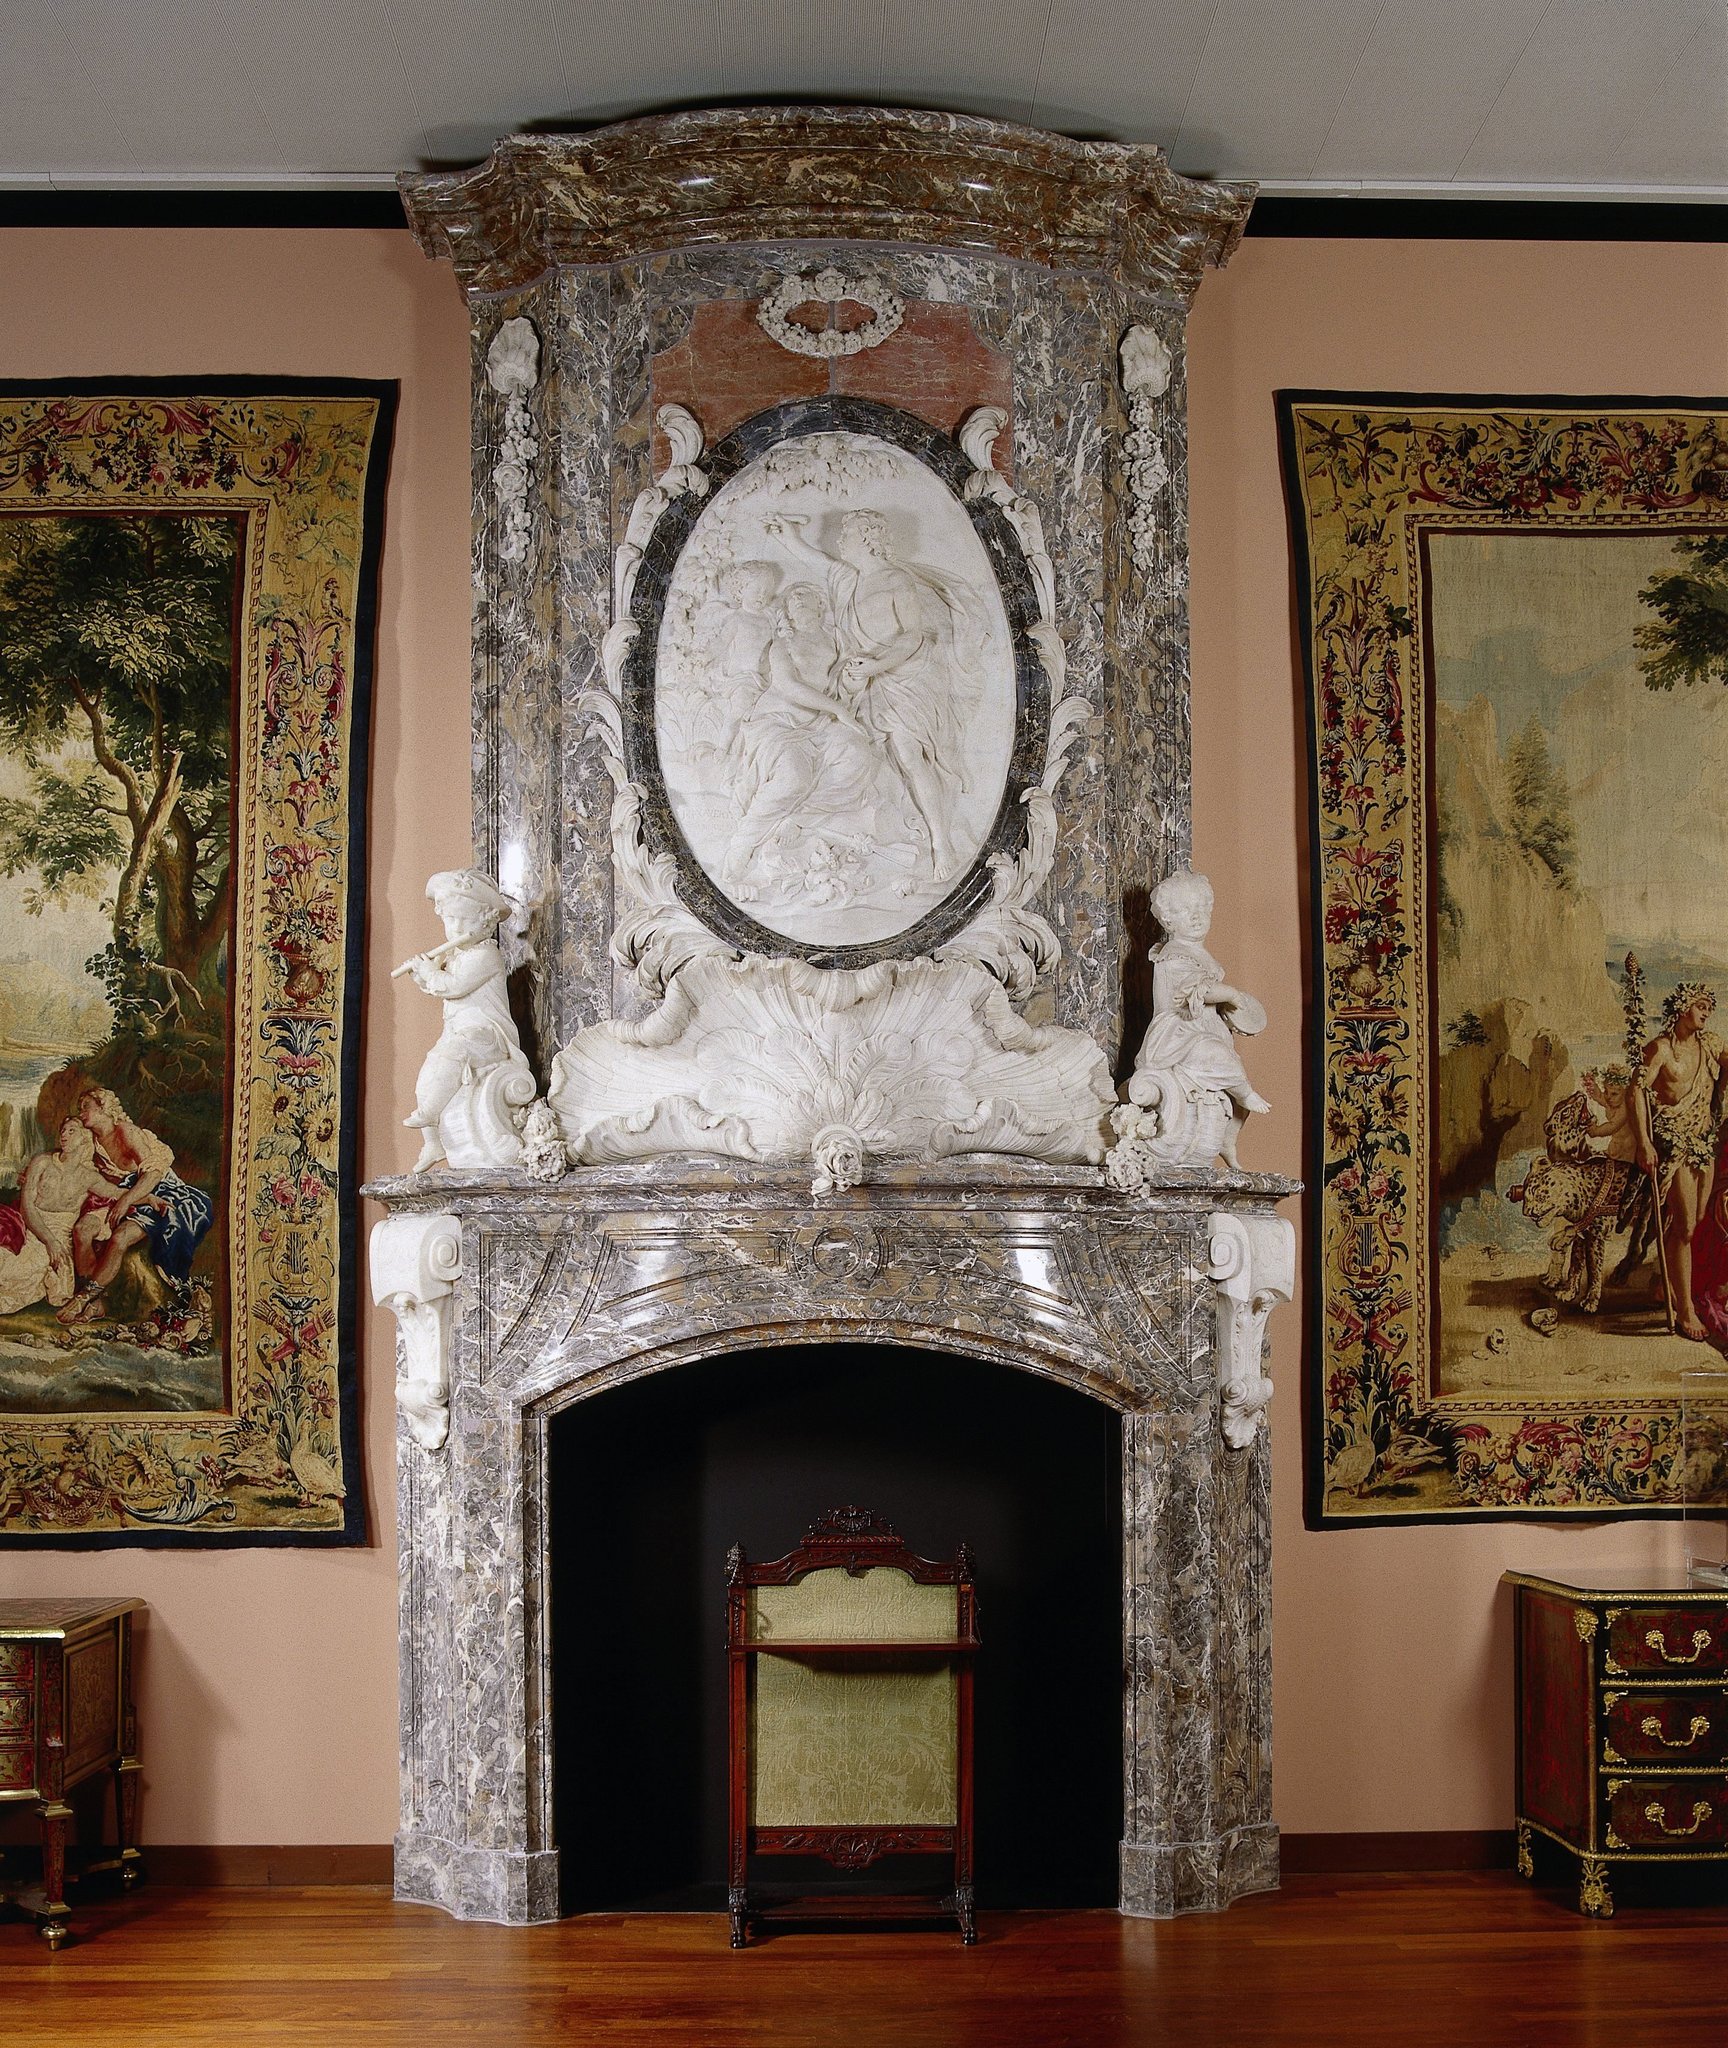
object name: scow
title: Mantelpiece with relief of Paris and Oenone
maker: jan baptist xavery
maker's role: sculptor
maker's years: 1697-1742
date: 1739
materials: marble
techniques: relief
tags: transverse flute, tambourine, (story of) cupid, amor (eros), paris and oenone carving their names in a tree, pastorals, arcadian scenes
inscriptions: signature and date: ‘J.B.XAVERY. // ANNO 1739’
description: This mantelpiece was made for the principal room of the house at 48 Rapenburg in Leiden, where Diederik, Baron van Leyden, lived. Xavery also made a marble relief for each overdoor and probably designed the decorative stucco ceiling, which surrounded a large painting by Jacob de Wit. The walls were hung with tapestries from Brussels. This created an impressive ensemble.